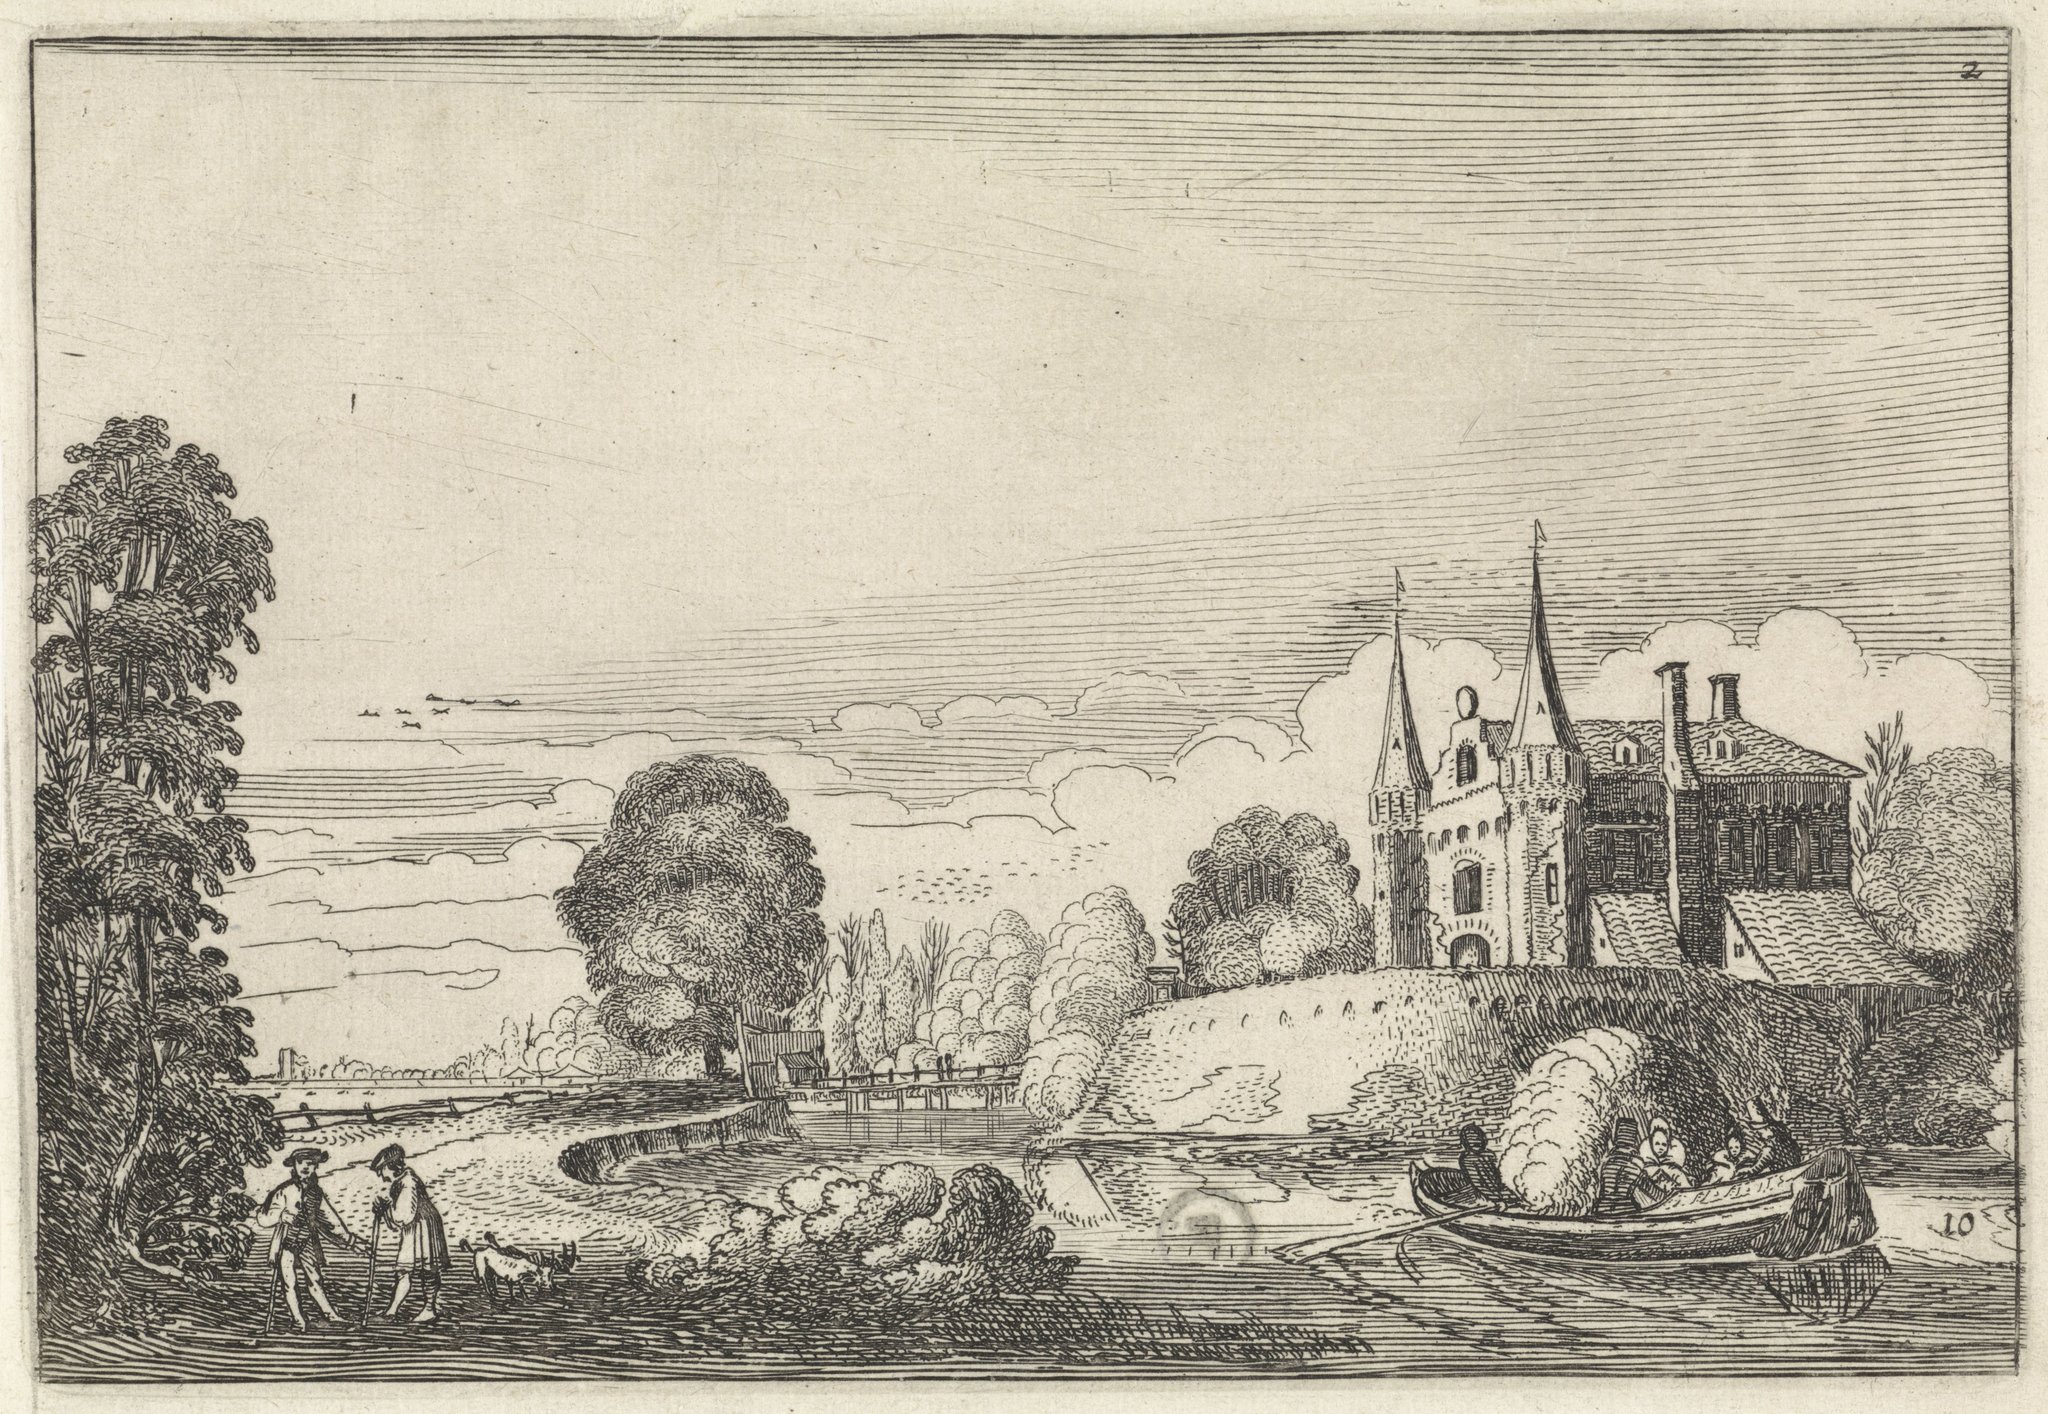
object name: print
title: Landschappen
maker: jan van de velde (ii)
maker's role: draughtsman, painter, print maker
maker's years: 1593-1641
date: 1616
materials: paper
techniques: etching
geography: northern netherlands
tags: fortress, moat ~ fortified city, castle, landscape with tower or castle, rowing facing backward, pulling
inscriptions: collector's mark: Lugt 964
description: Figuren in een plezierboot op het water van een slotgracht rondom een kasteel met twee torens. Links op de oever twee figuren. Tiende prent van deel twee van een serie van in totaal zestig prenten met landschappen, verdeeld over vijf delen van elk twaalf prenten.